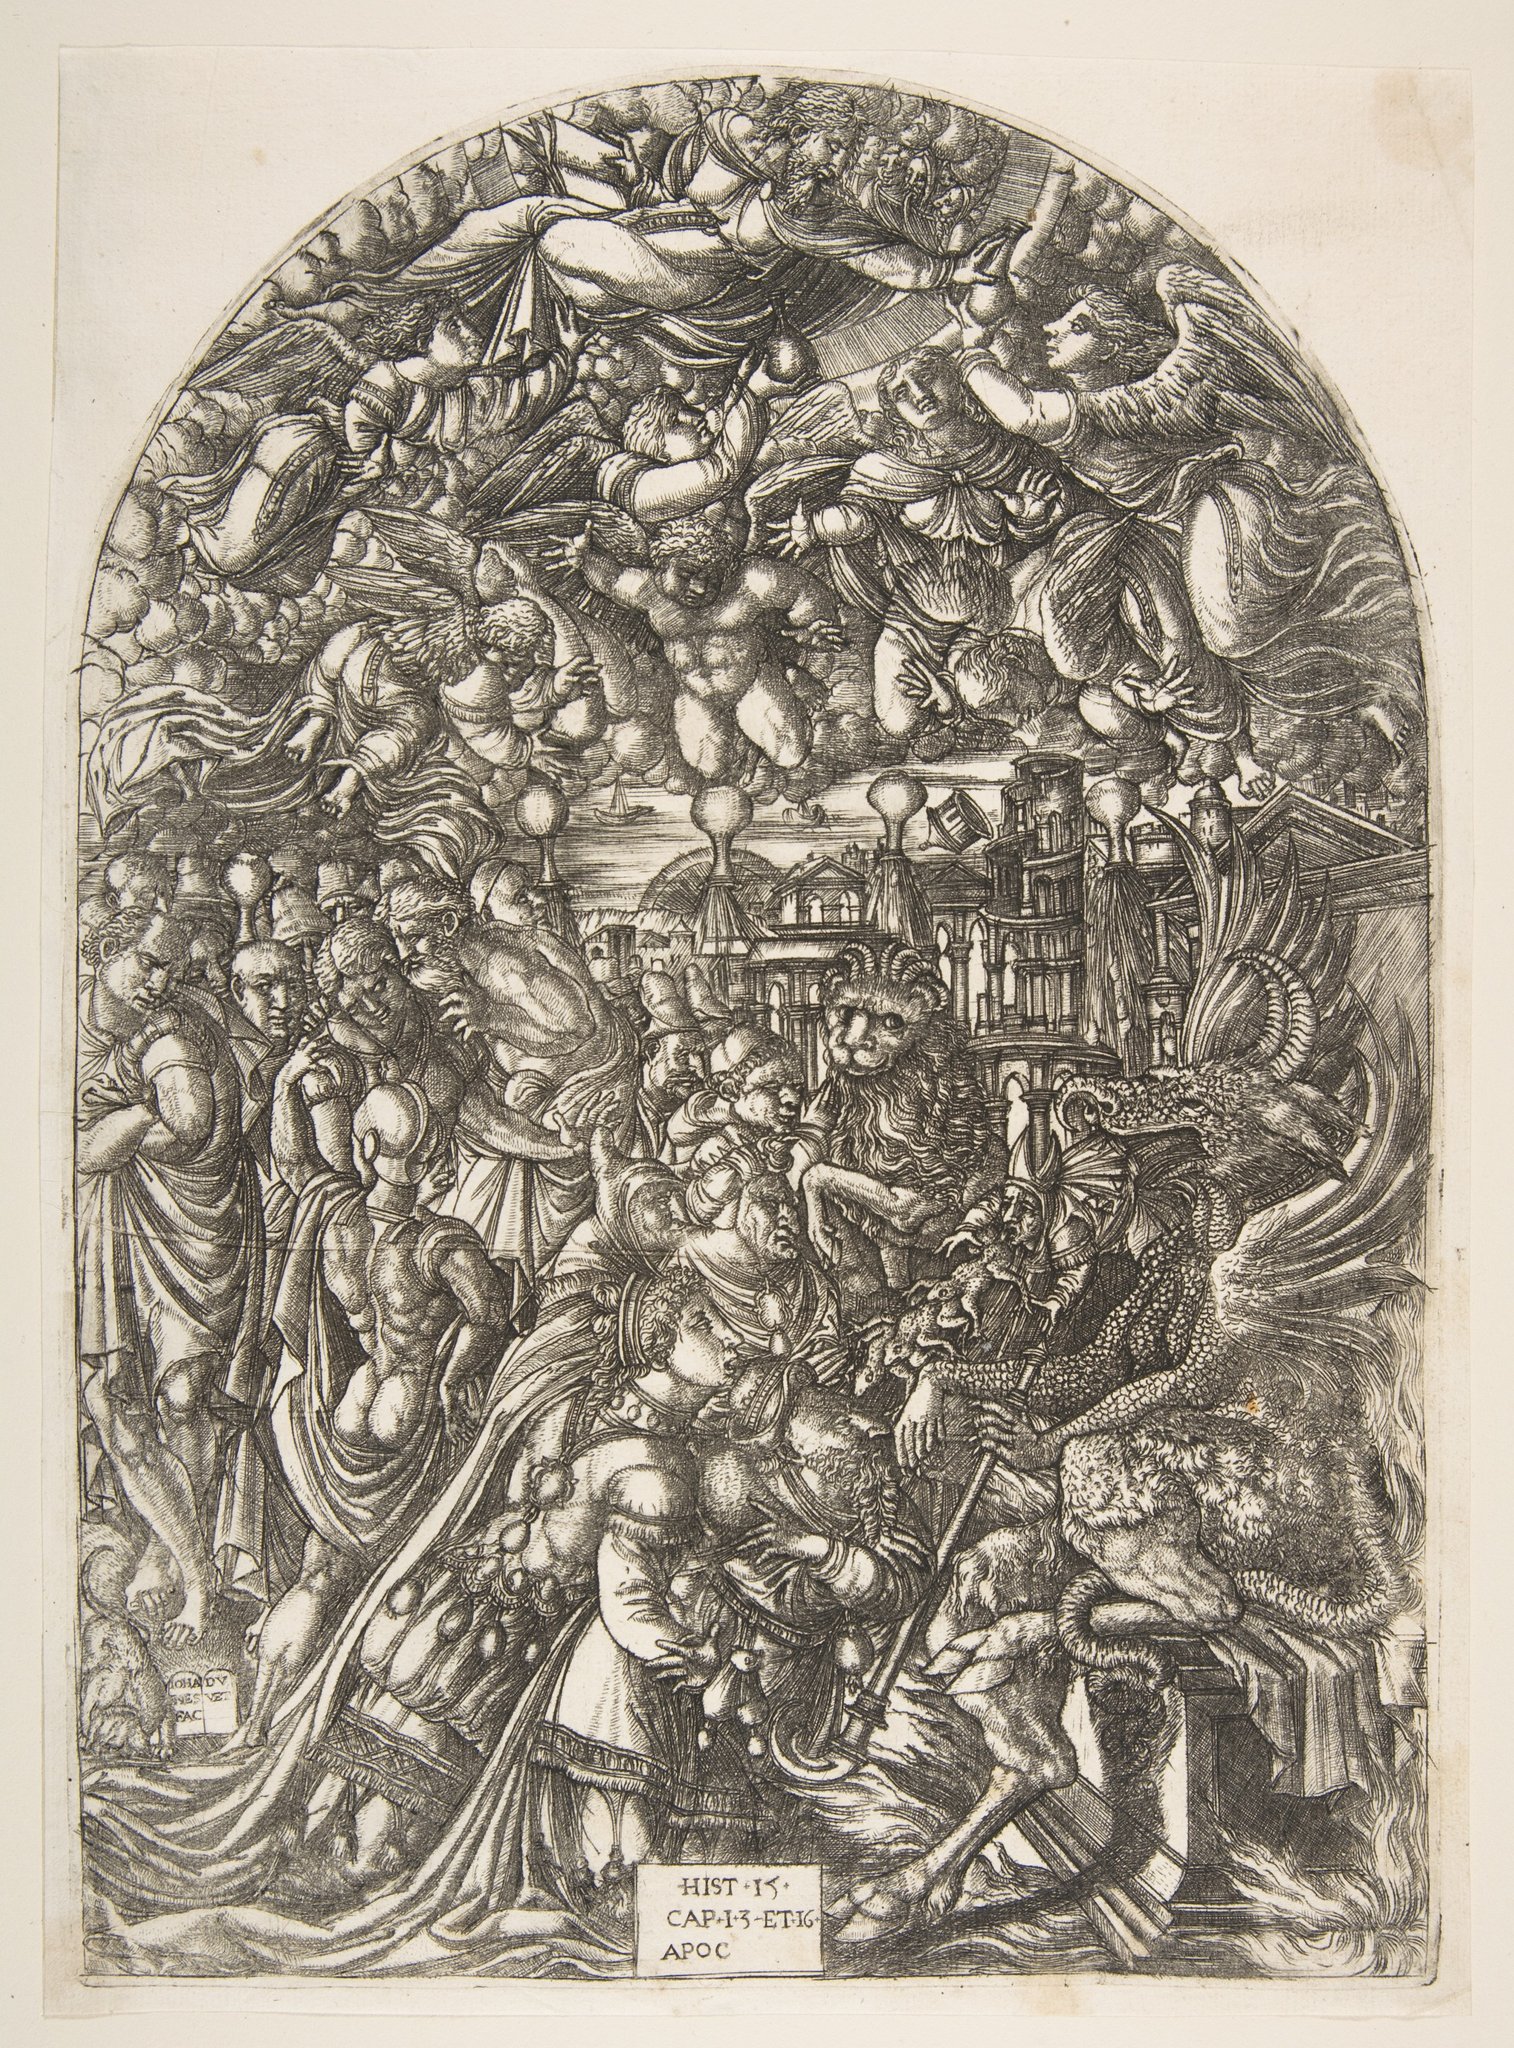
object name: print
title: The Dragon with two Horns and the Beast with Seven, from the Apocalypse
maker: jean duvet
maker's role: artist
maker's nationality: french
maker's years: 1485-1561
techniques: engraving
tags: dragons